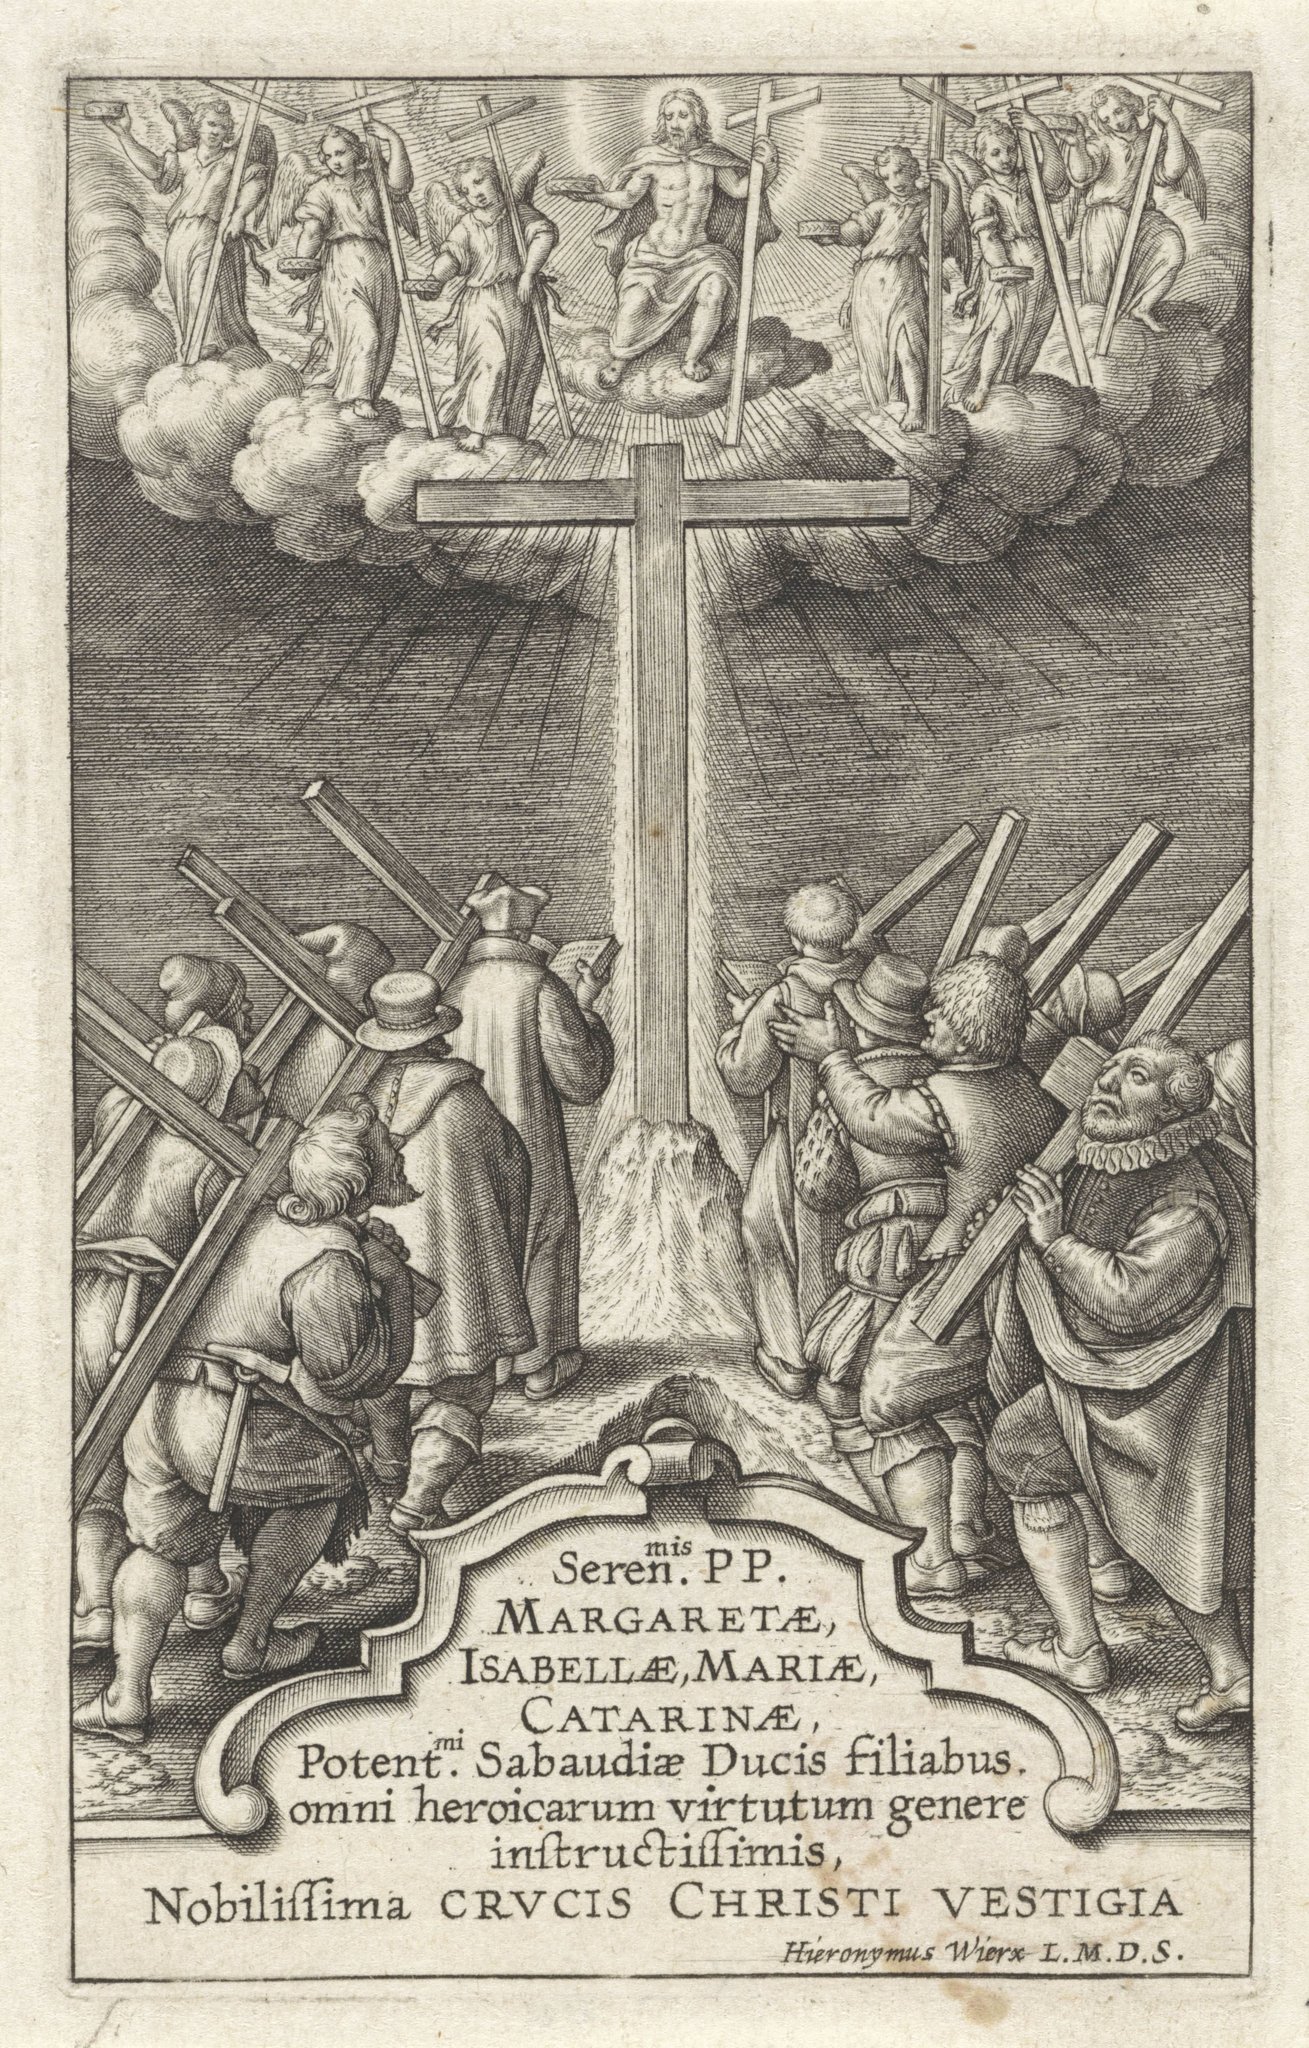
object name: print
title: Volgelingen van Christus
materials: paper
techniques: engraving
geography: antwerp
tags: christ (+ angel(s)), the cross ~ symbols of christ, the believer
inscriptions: number: ‘38. - 60’, collector's mark: Lugt 240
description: Een stoet mannen, elk met een kruis op de rug, loopt in de richting van het kruis dat op een heuvel staat. Boven het kruis in de hemel troont Christus. In zijn ene hand houdt hij een kruis, in zijn andere een kroon. Hij wordt geflankeerd door engelen met kruizen. In het cartouche onder de voorstelling een opdracht in het Latijn.